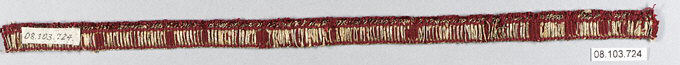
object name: gimp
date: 1501-1600